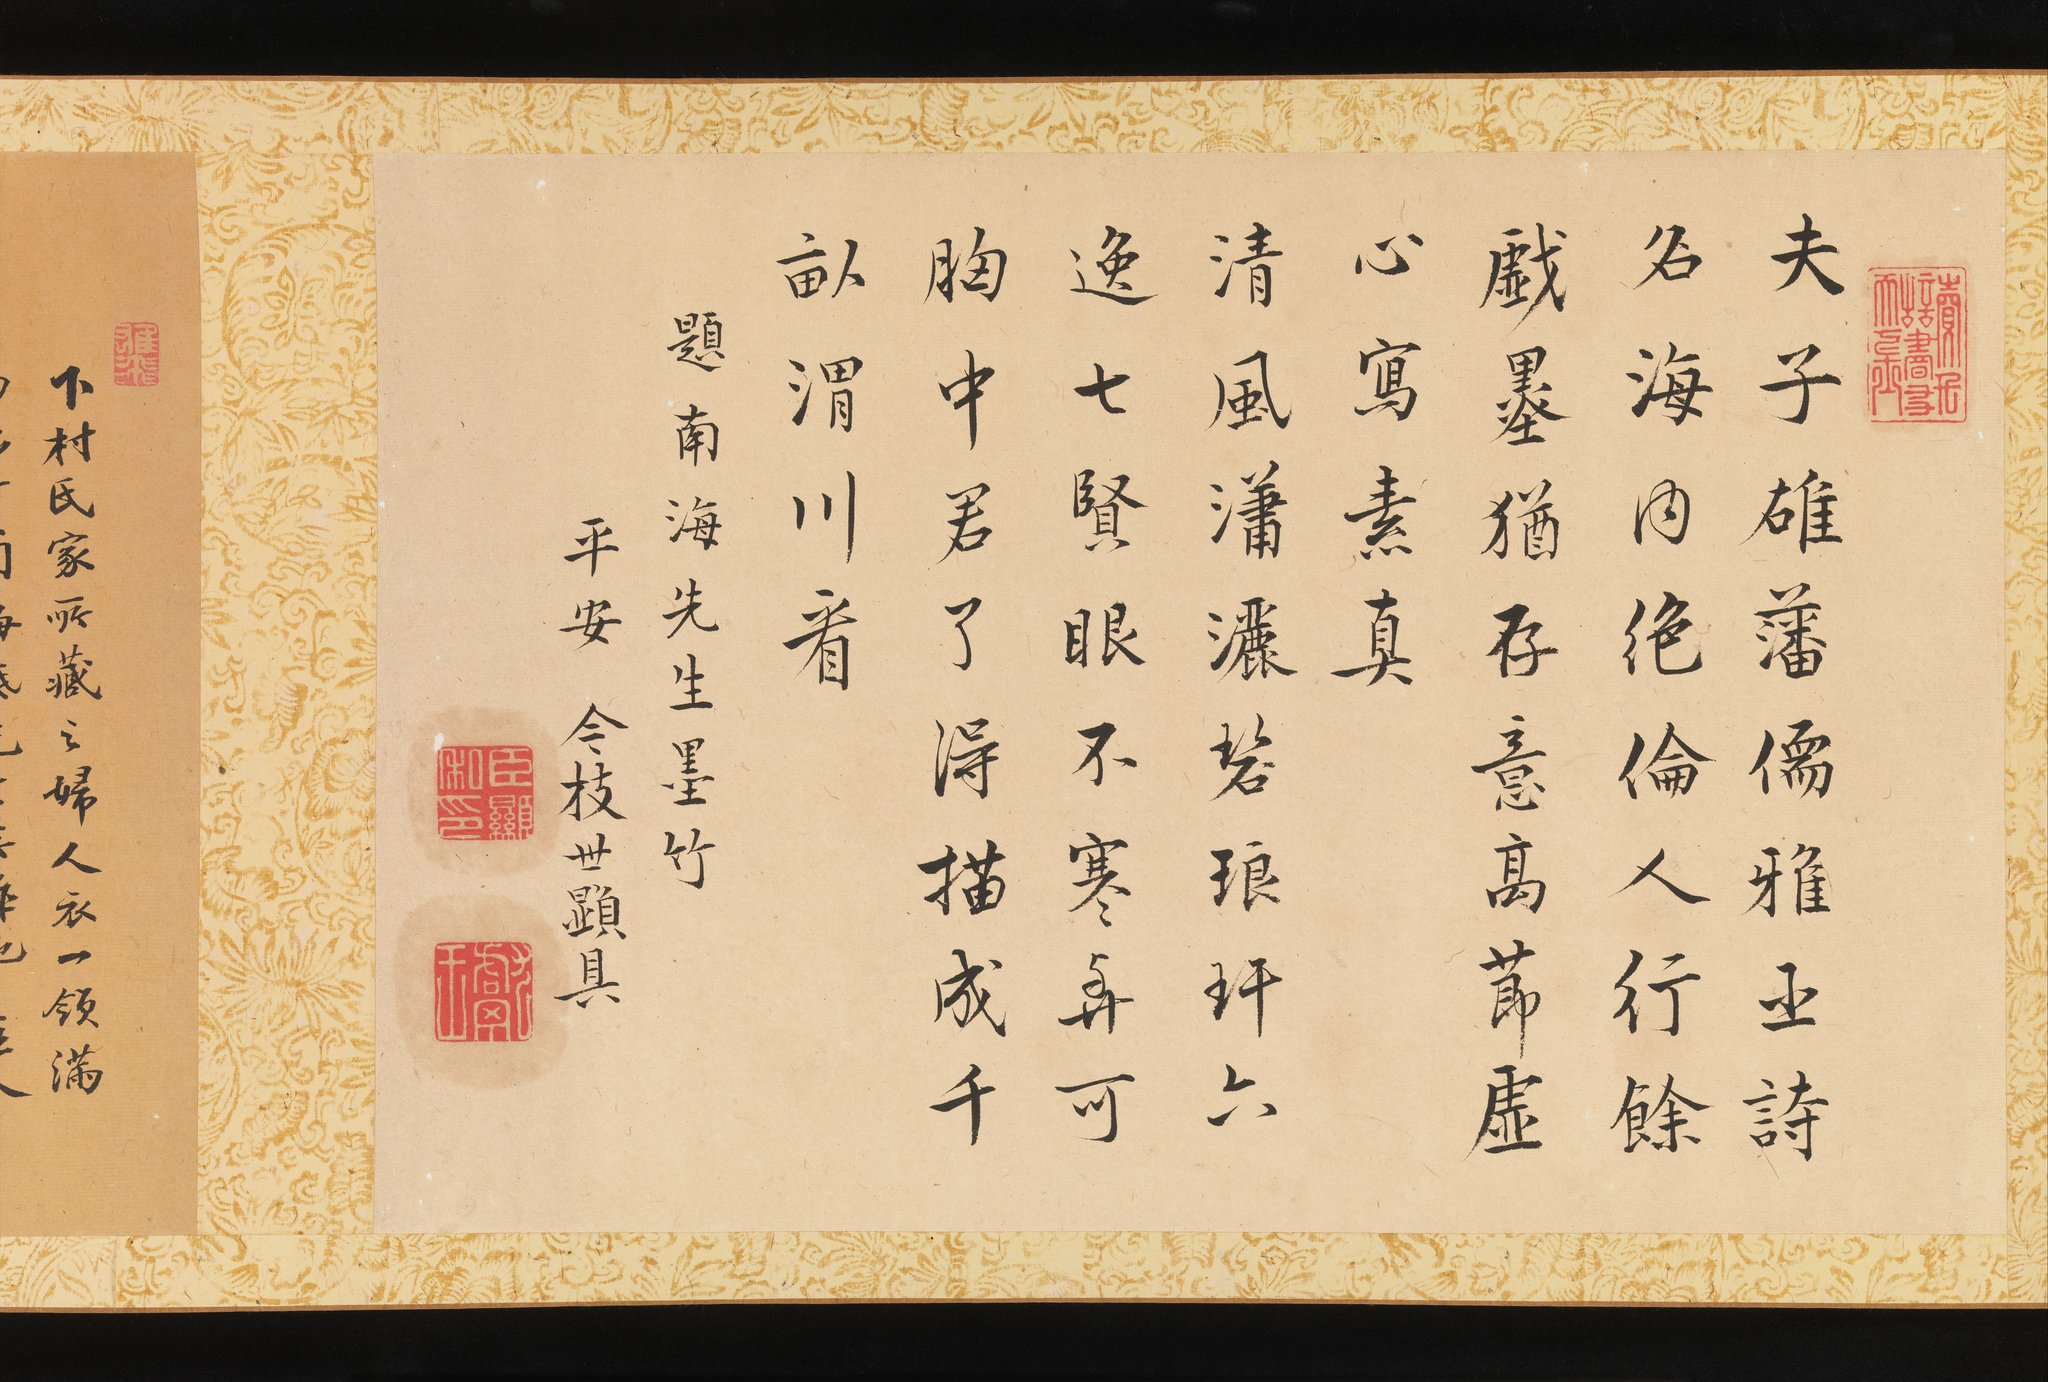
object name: handscroll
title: Poem Accompanying an Over Robe (Uchikake) with a Bamboo Painting by Gion Nankai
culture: japanese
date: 1824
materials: ink, paper